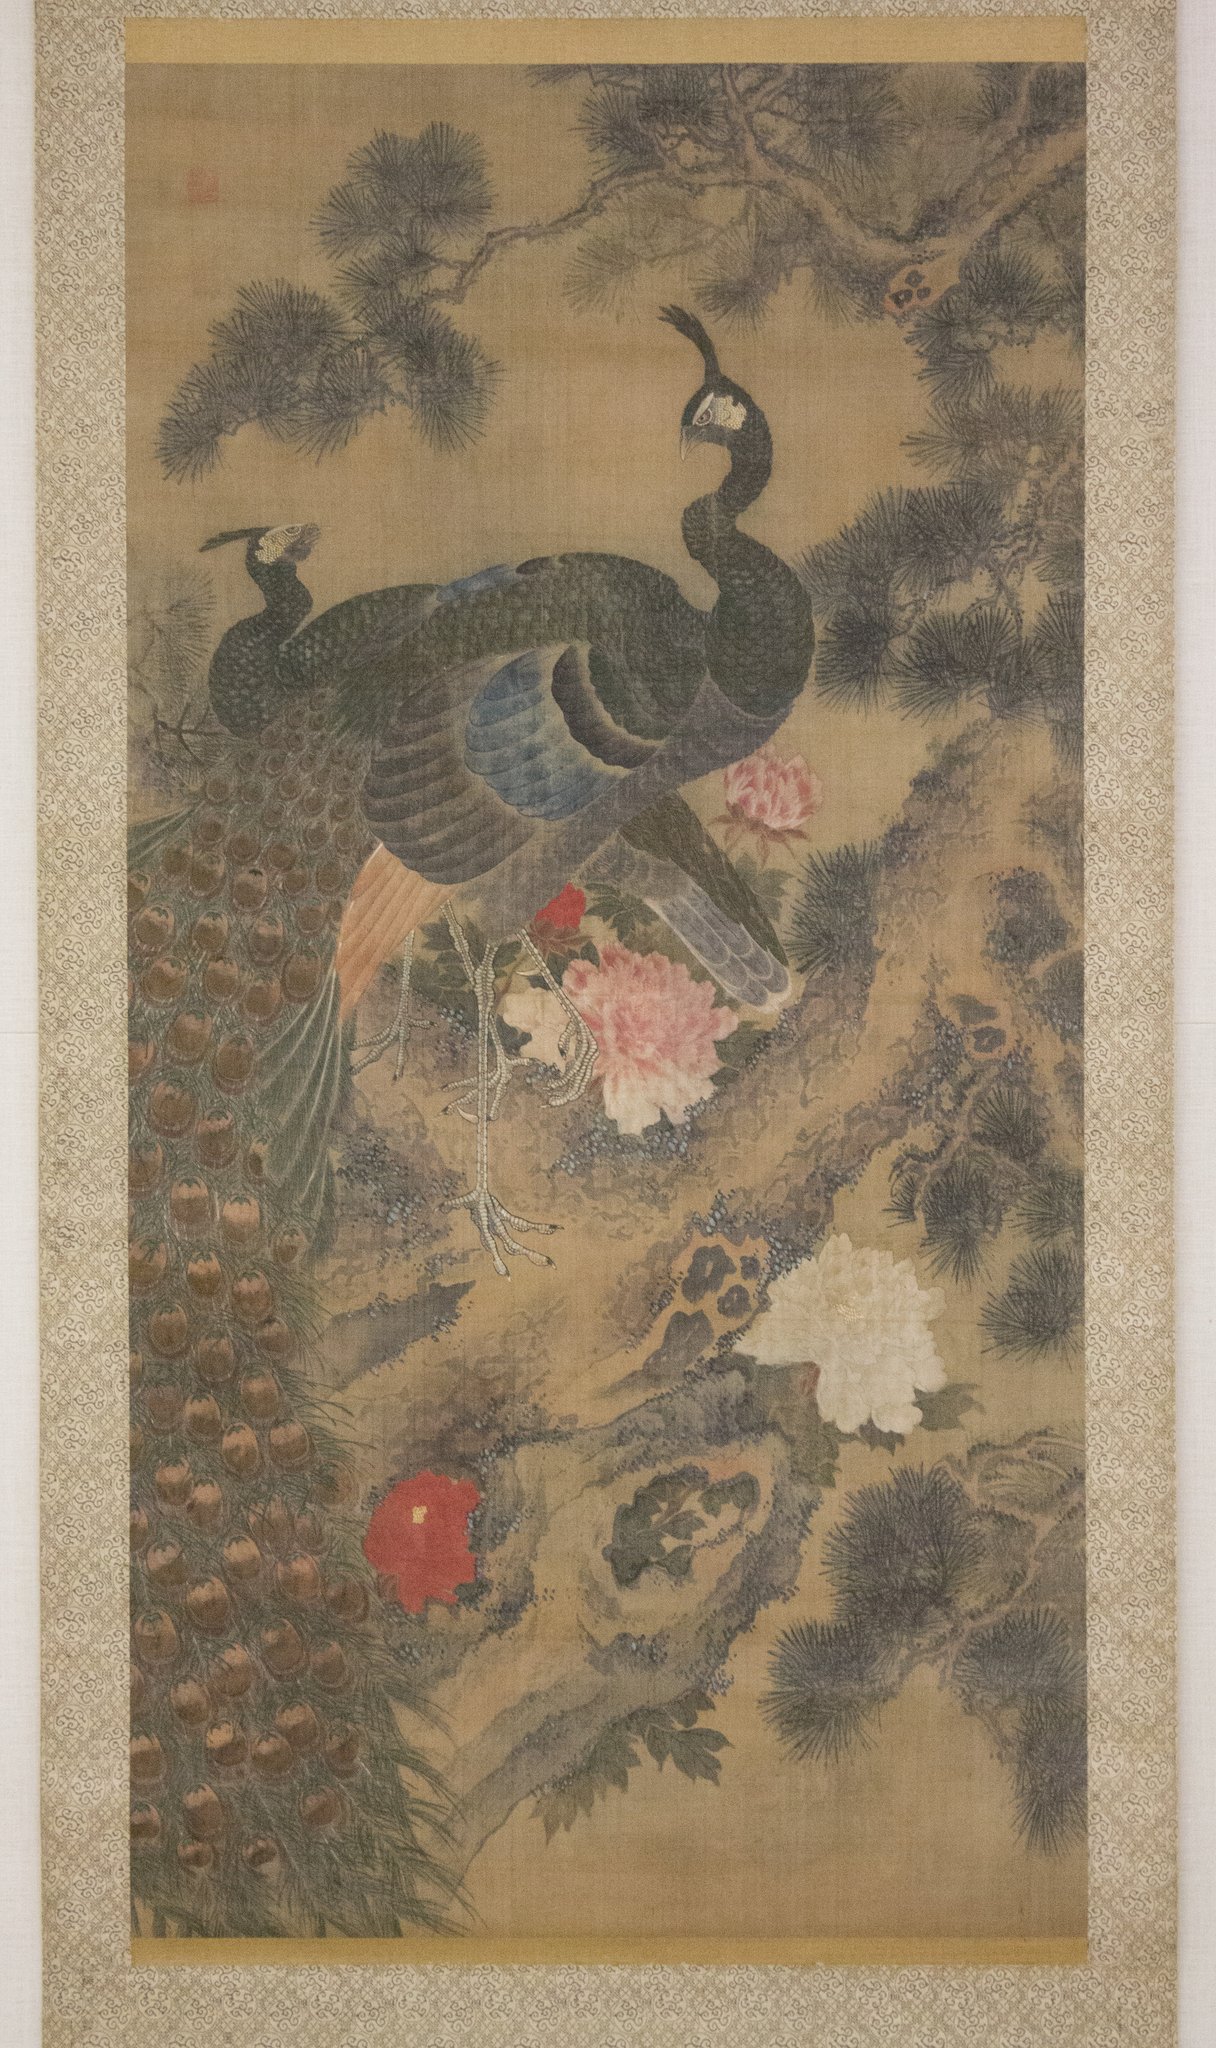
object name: hanging scroll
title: Peacocks, Pine Tree, and Peonies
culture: japanese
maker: lü ji 呂紀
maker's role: artist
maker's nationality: chinese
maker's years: 1430-1504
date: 1801-1900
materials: ink, silk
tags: peacocks